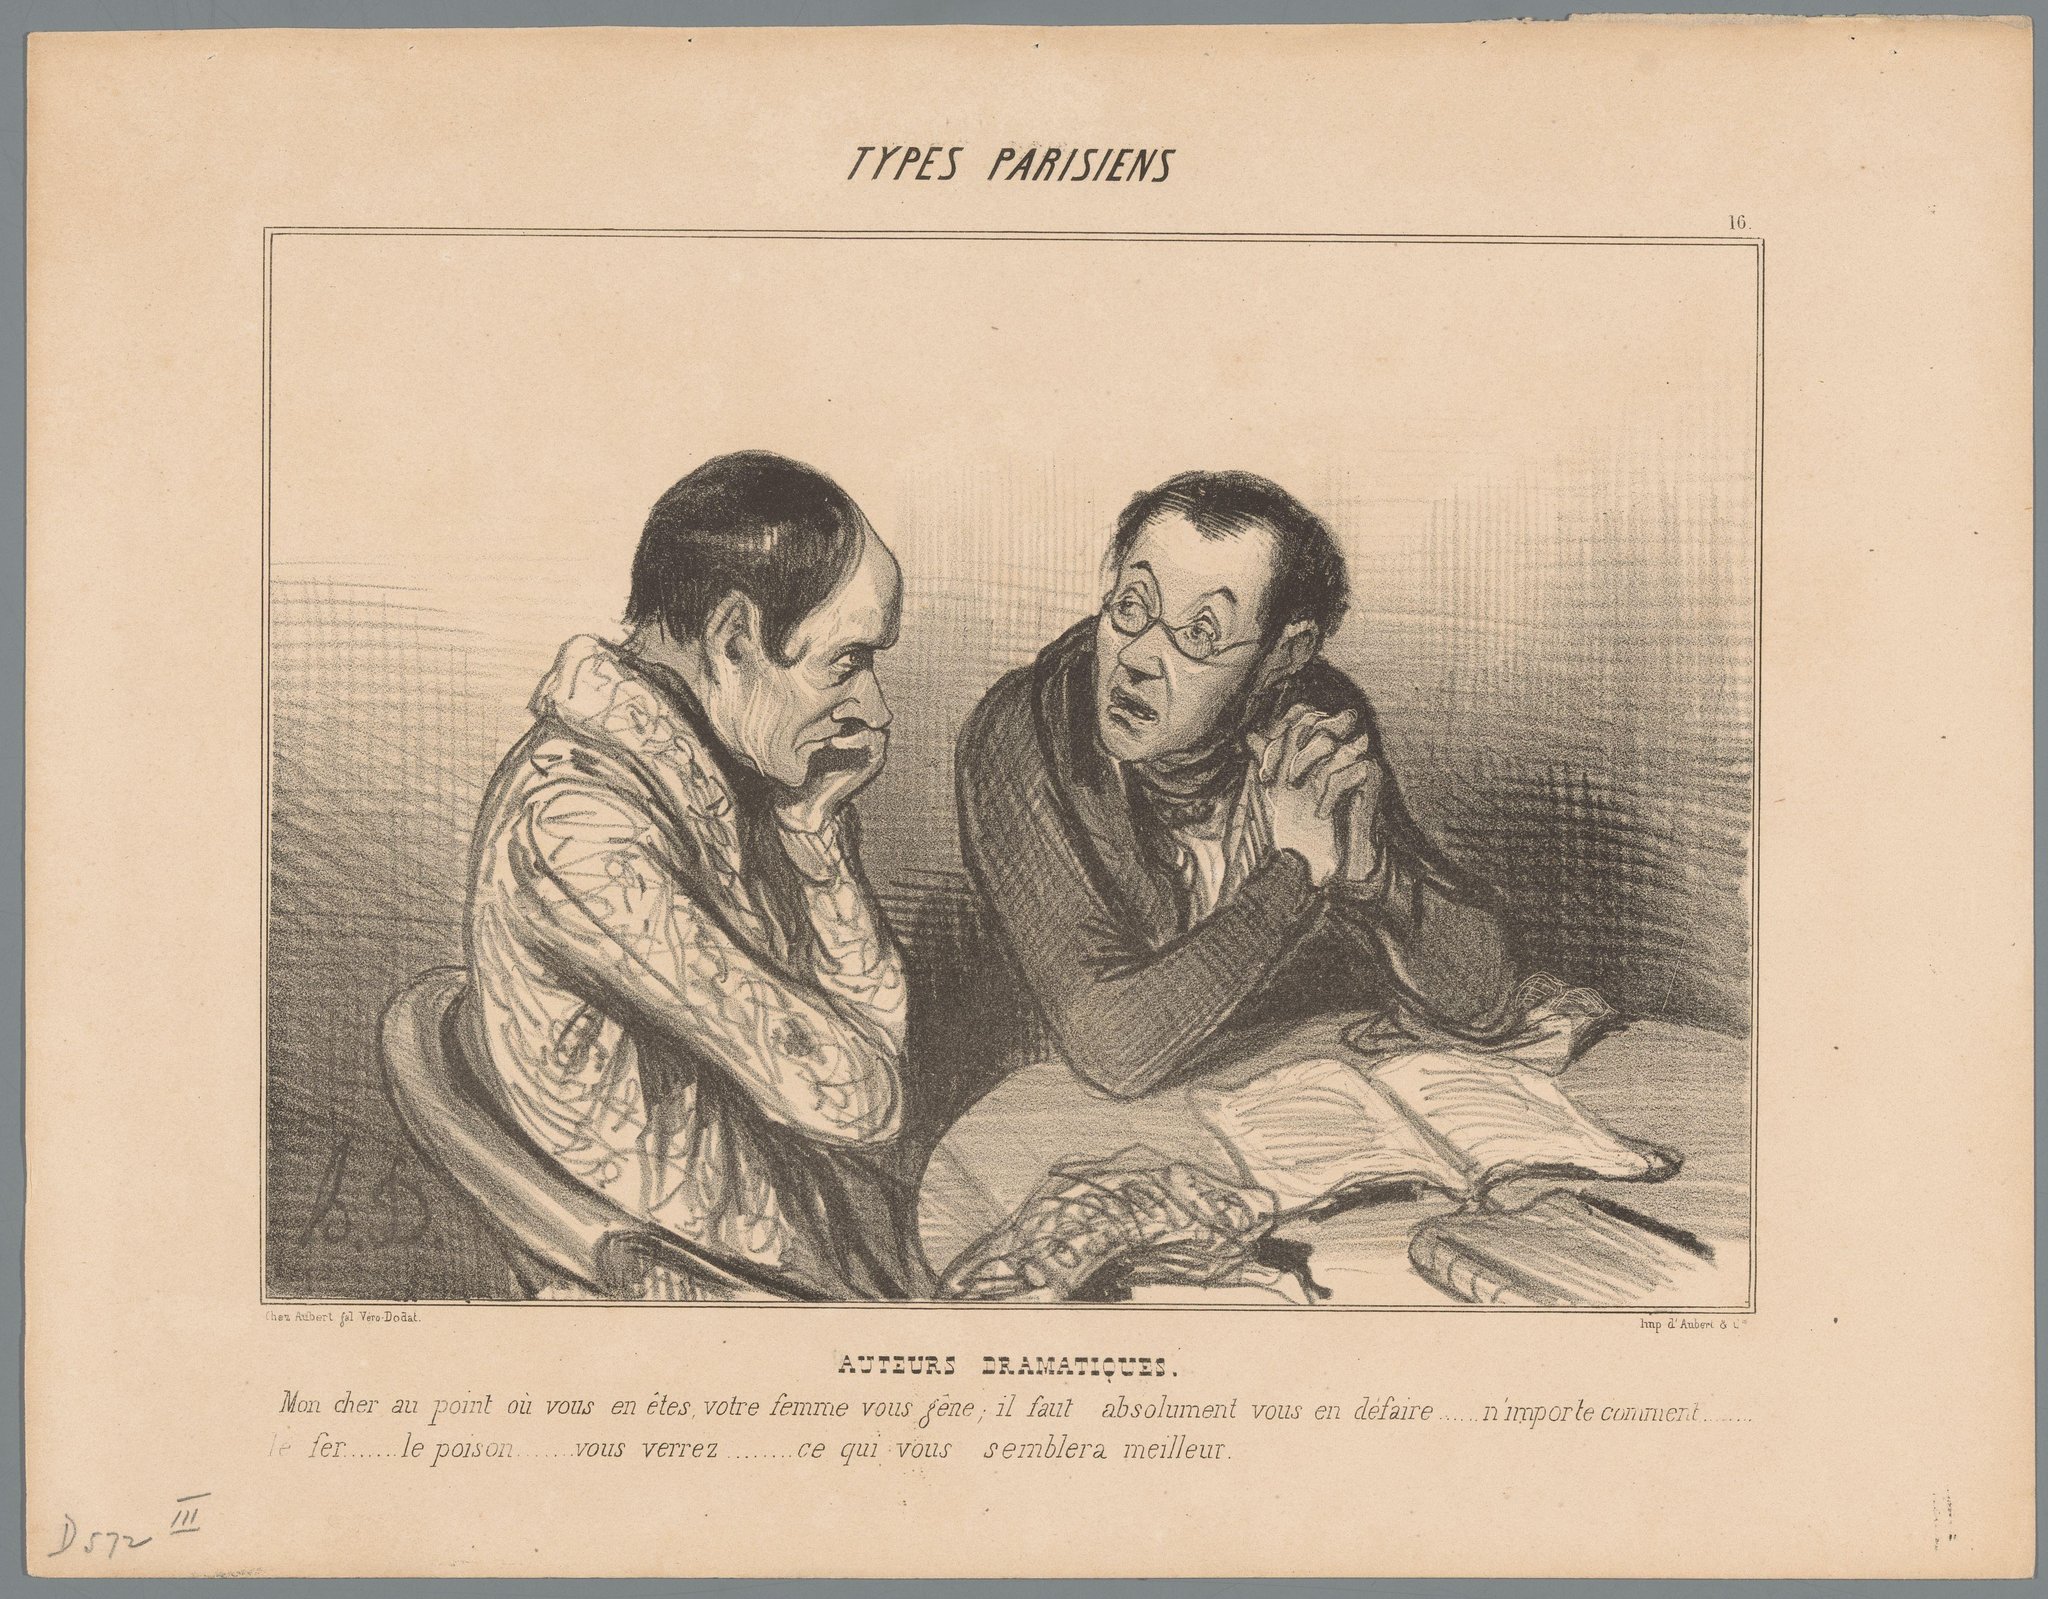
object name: cartoon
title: Auteurs dramatiques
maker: honoré daumier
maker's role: draughtsman, painter, print maker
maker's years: 1808-1879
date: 1839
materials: paper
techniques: letterpress printing, lithograph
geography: paris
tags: caricatures (human types), writer, poet, author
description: Prent uit: Le Figaro, 24 november 1839. Latere staat gebruikt in: Le Charivari, 24 juni 1841.